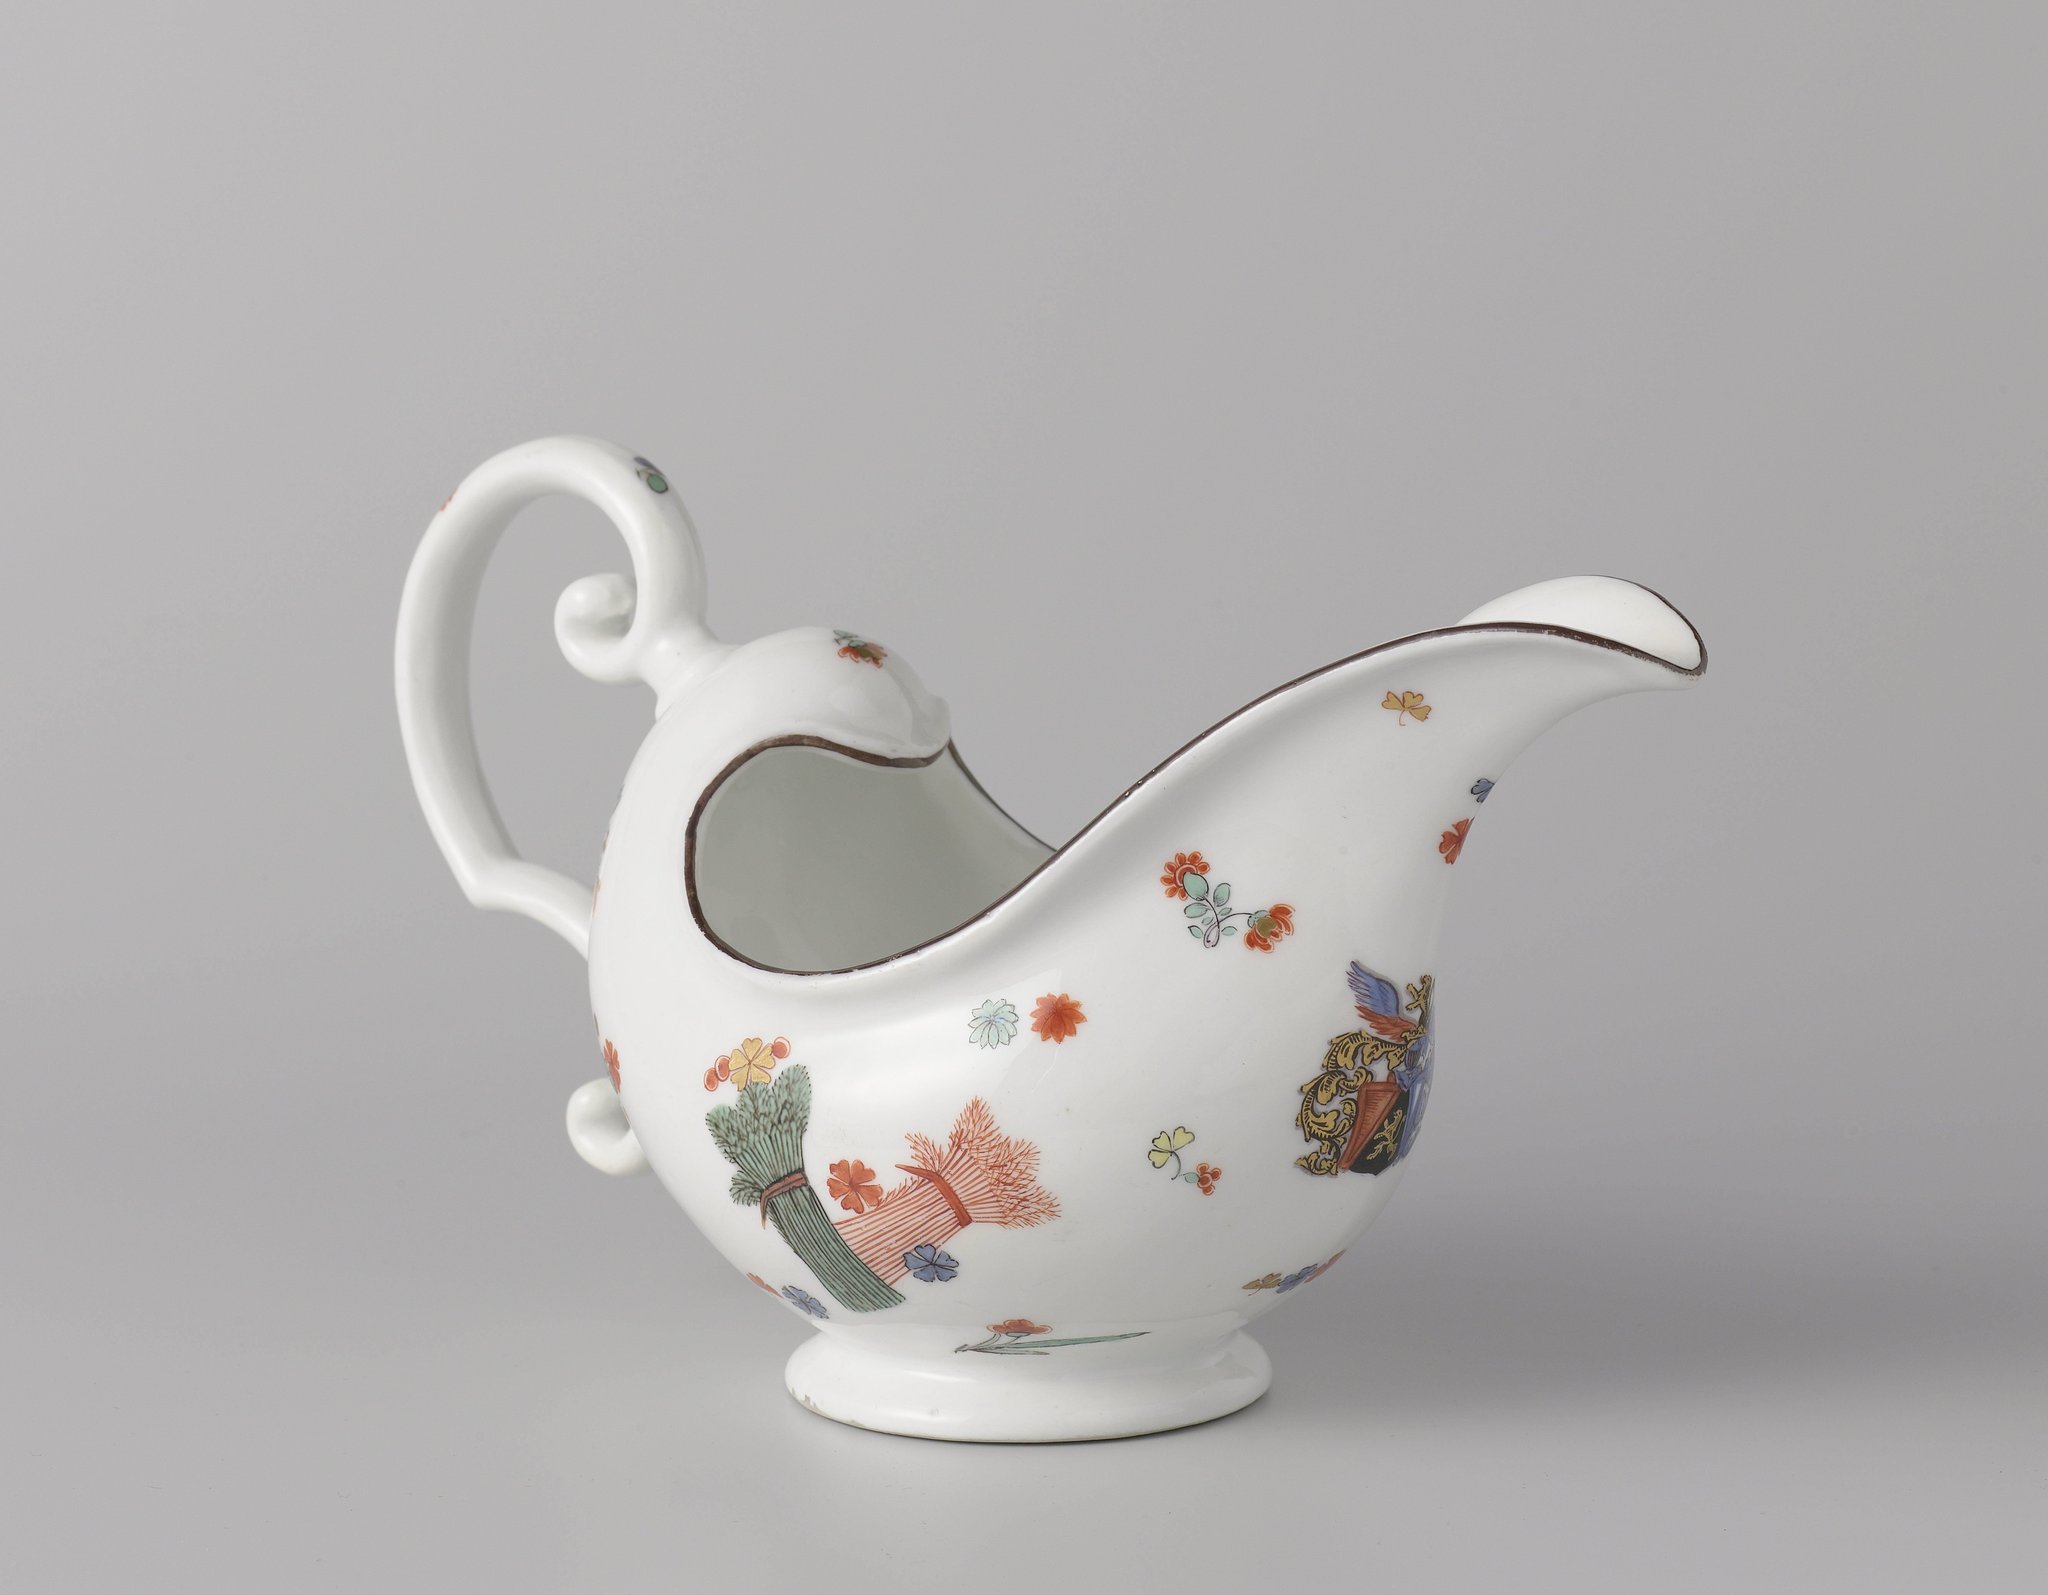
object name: sauceboat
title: Sauskom, veelkleurig beschilderd met een Kakiemon-decor en het wapen van Johann Christian graaf von Hennicke (1681-1752)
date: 1735-1740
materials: porcelain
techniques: painted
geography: meissen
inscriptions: factory mark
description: Two sauce boats from the service of Count Johann Christian von Hennicke. Porcelain. Meissen, c. 1735. Given by L. Mainz, 1938.